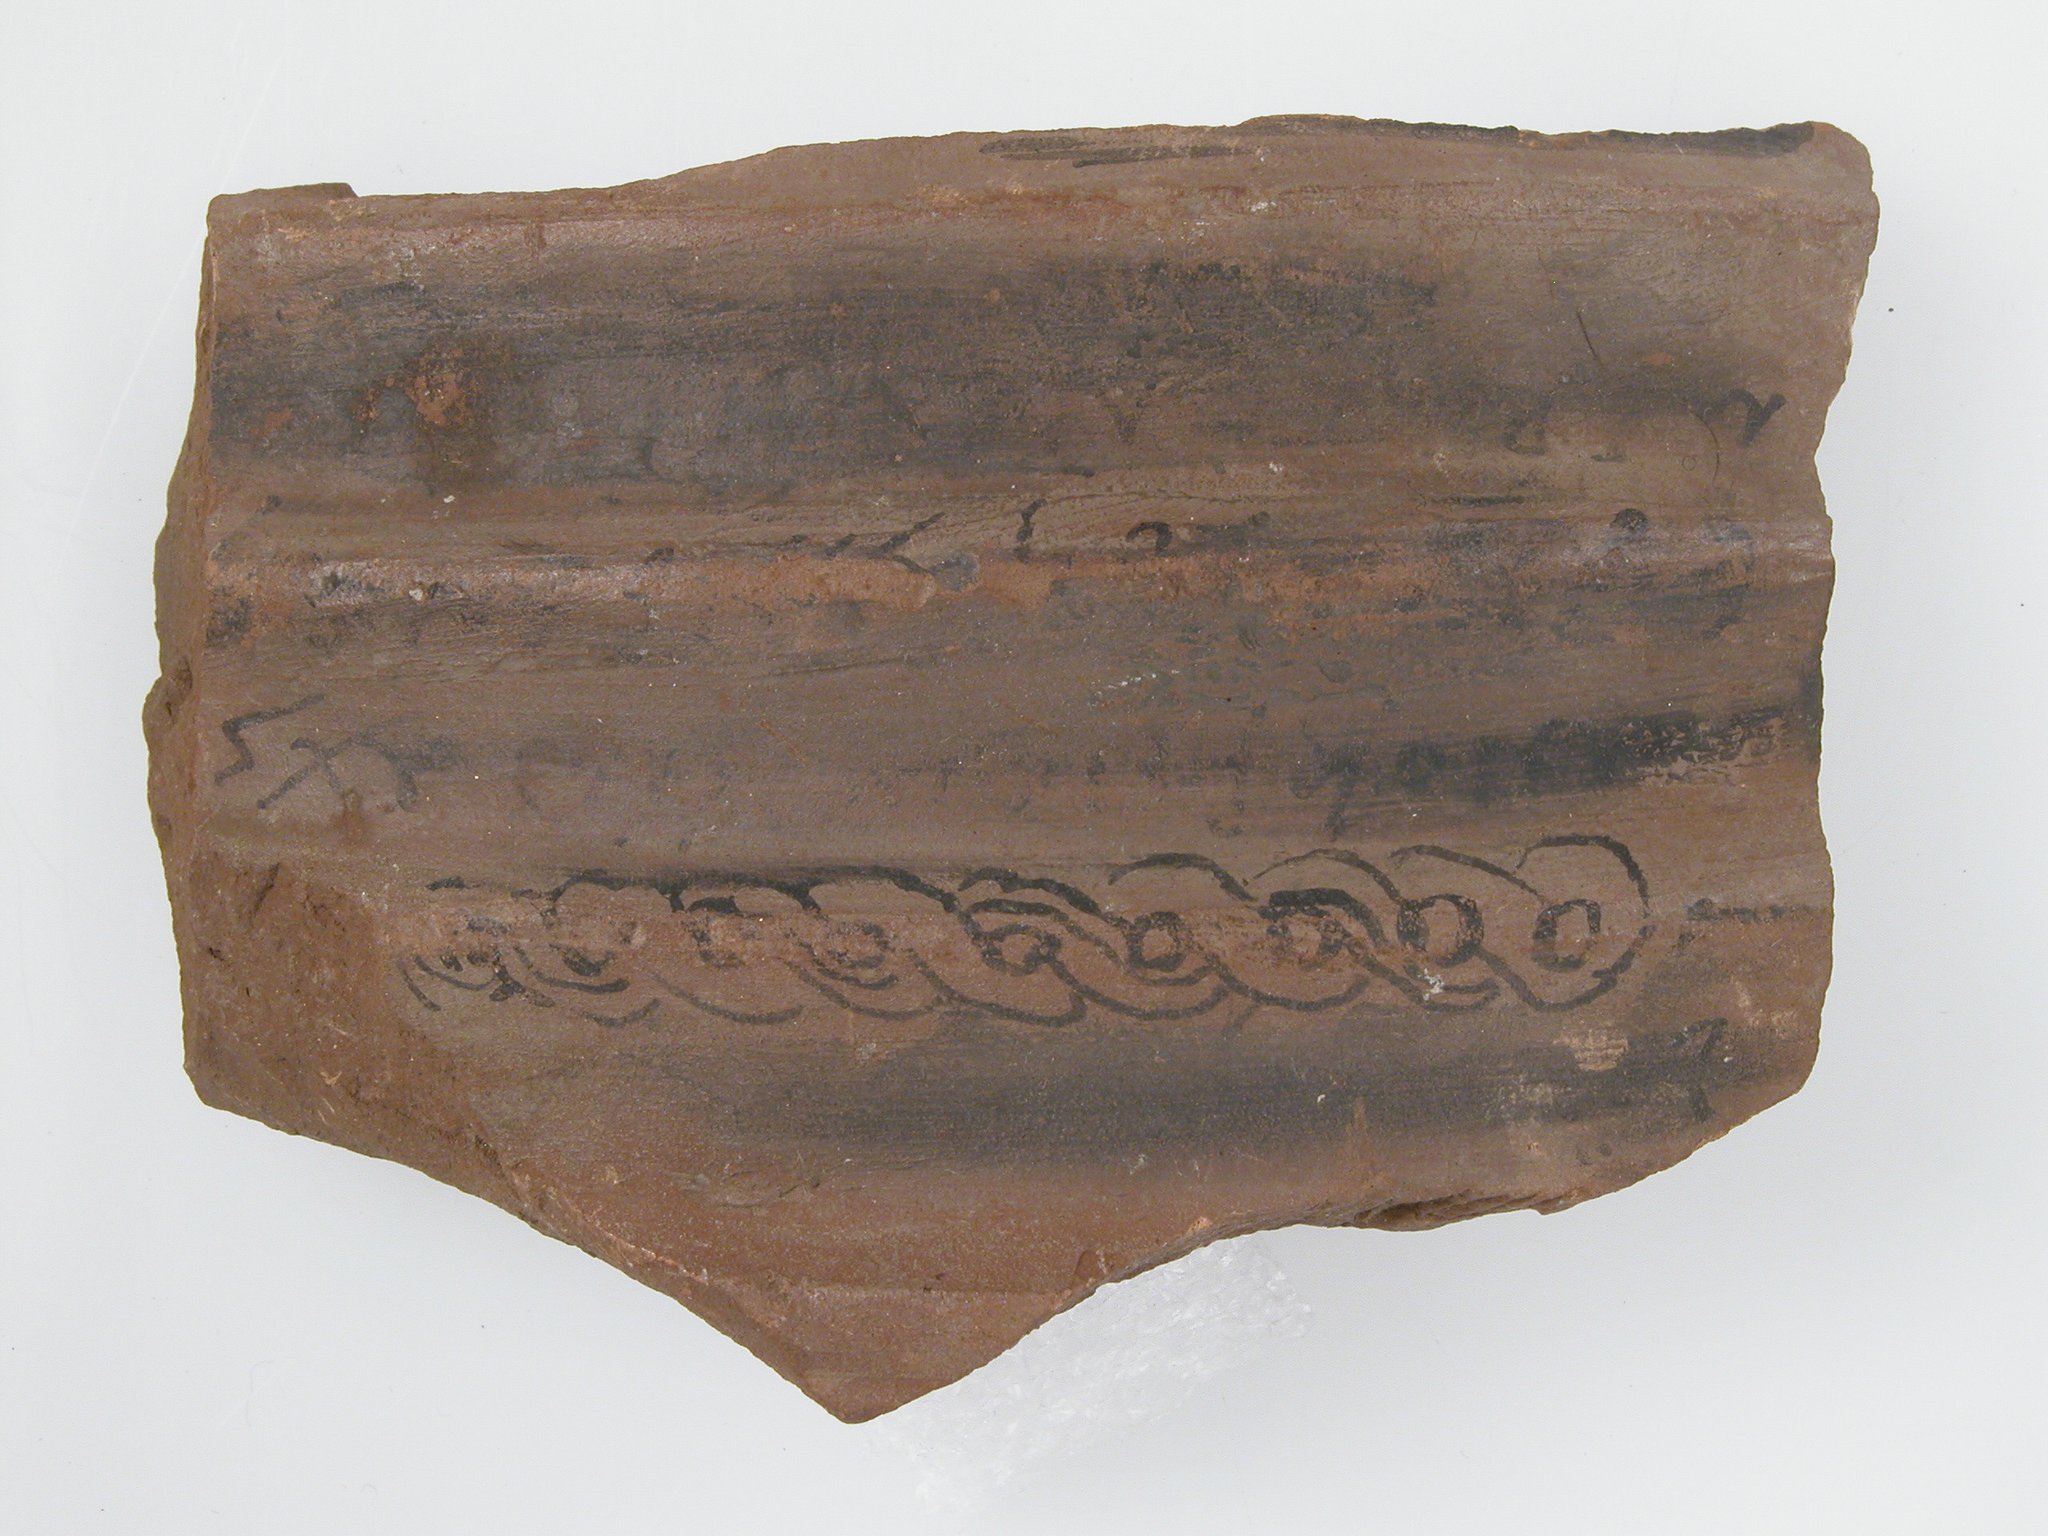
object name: ostrakon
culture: coptic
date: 601-700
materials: ink, pottery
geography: egypt